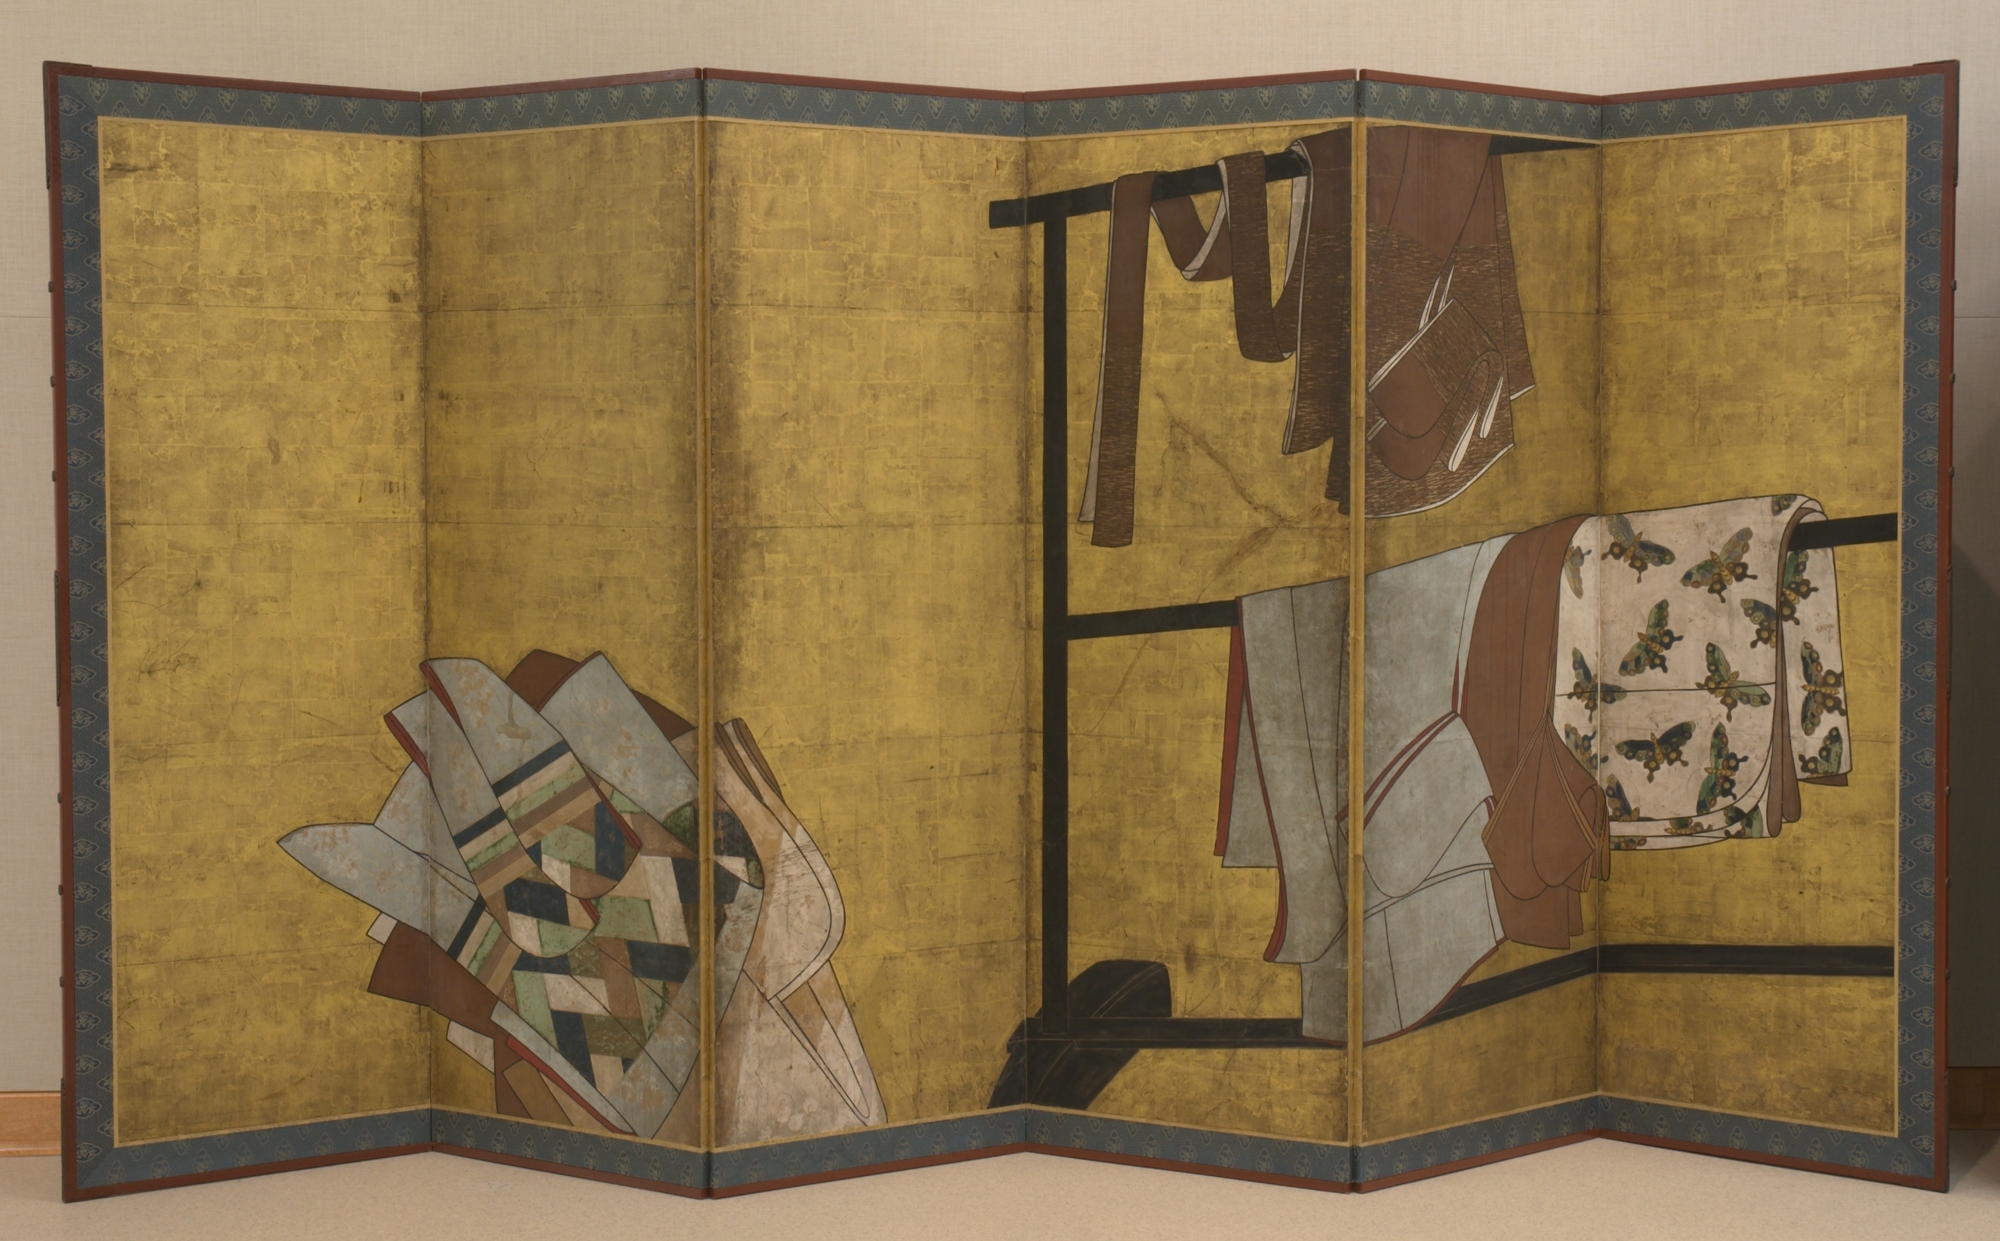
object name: screen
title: Whose Sleeves? (Tagasode)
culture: japanese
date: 1601-1700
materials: gold, ink, panel, paper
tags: robes,butterflies